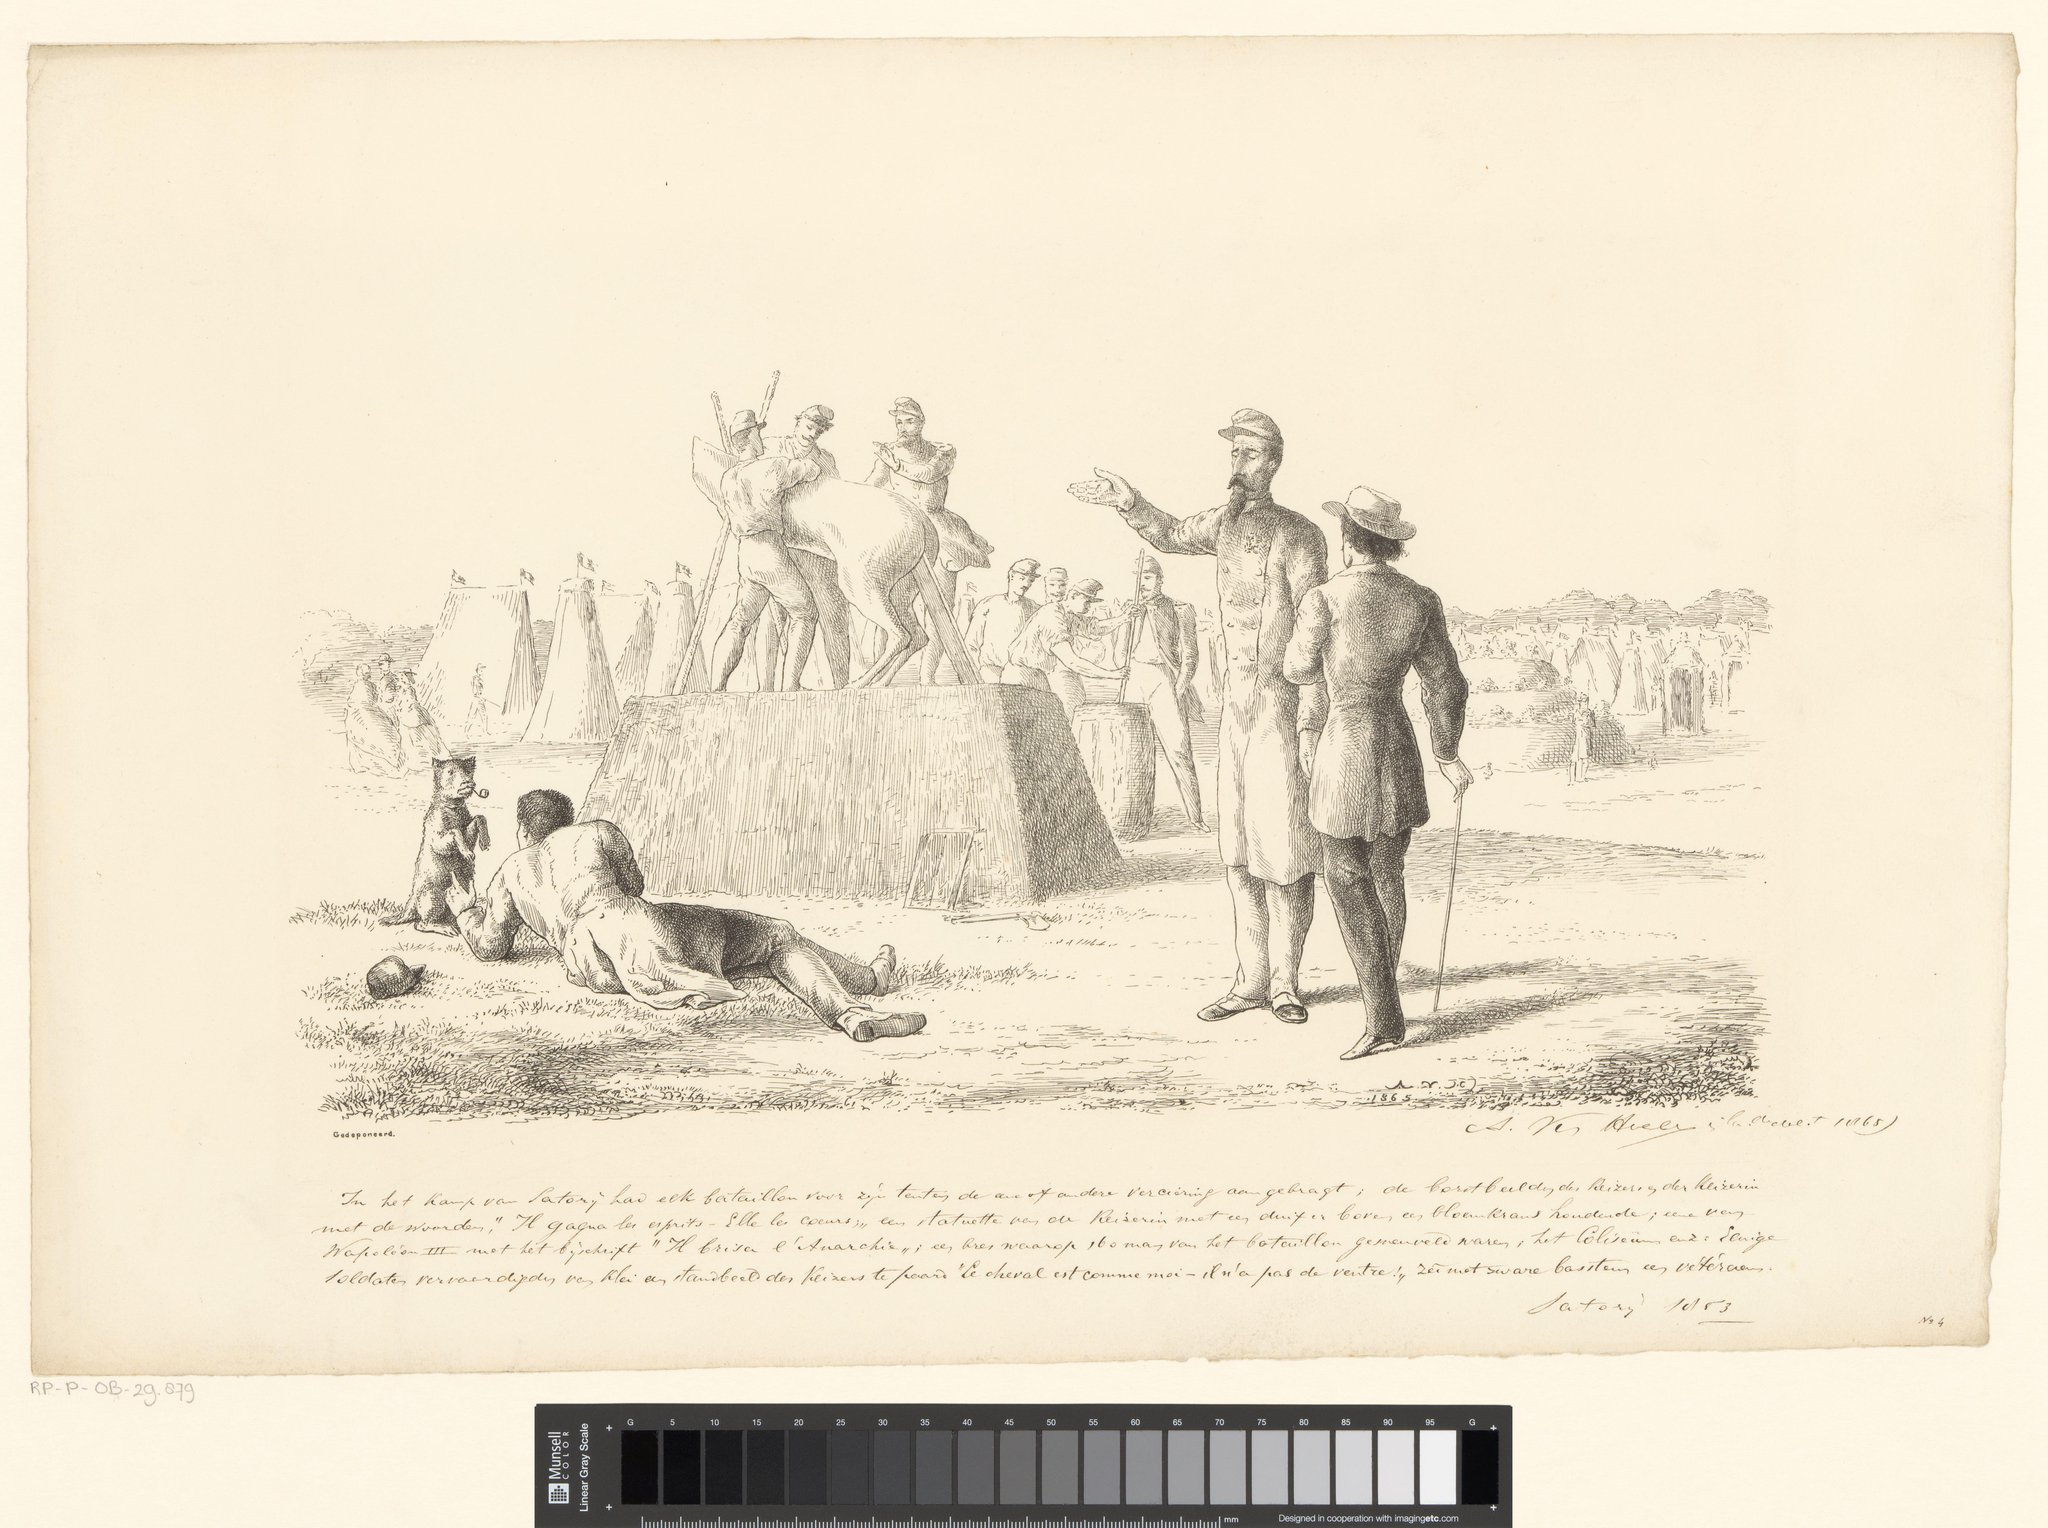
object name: print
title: Oprichting van een standbeeld in het kamp van Satory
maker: alexander ver huell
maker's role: draughtsman, print maker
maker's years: 1822-1897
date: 1864-1866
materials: paper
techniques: lithograph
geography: arnhem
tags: (military) camp with tents, piece of sculpture, reproduction of a piece of sculpture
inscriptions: collector's mark: Lugt 2228, : ‘Gedeponeerd.’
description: In het militaire kamp Satory, bij Versailles, richten drie mannen een standbeeld van een paard op. Rechts wijst een militair een man op de rug gezien op het beeld. Links ligt een man in het grijs bij een hond met een pijp in zijn bek.